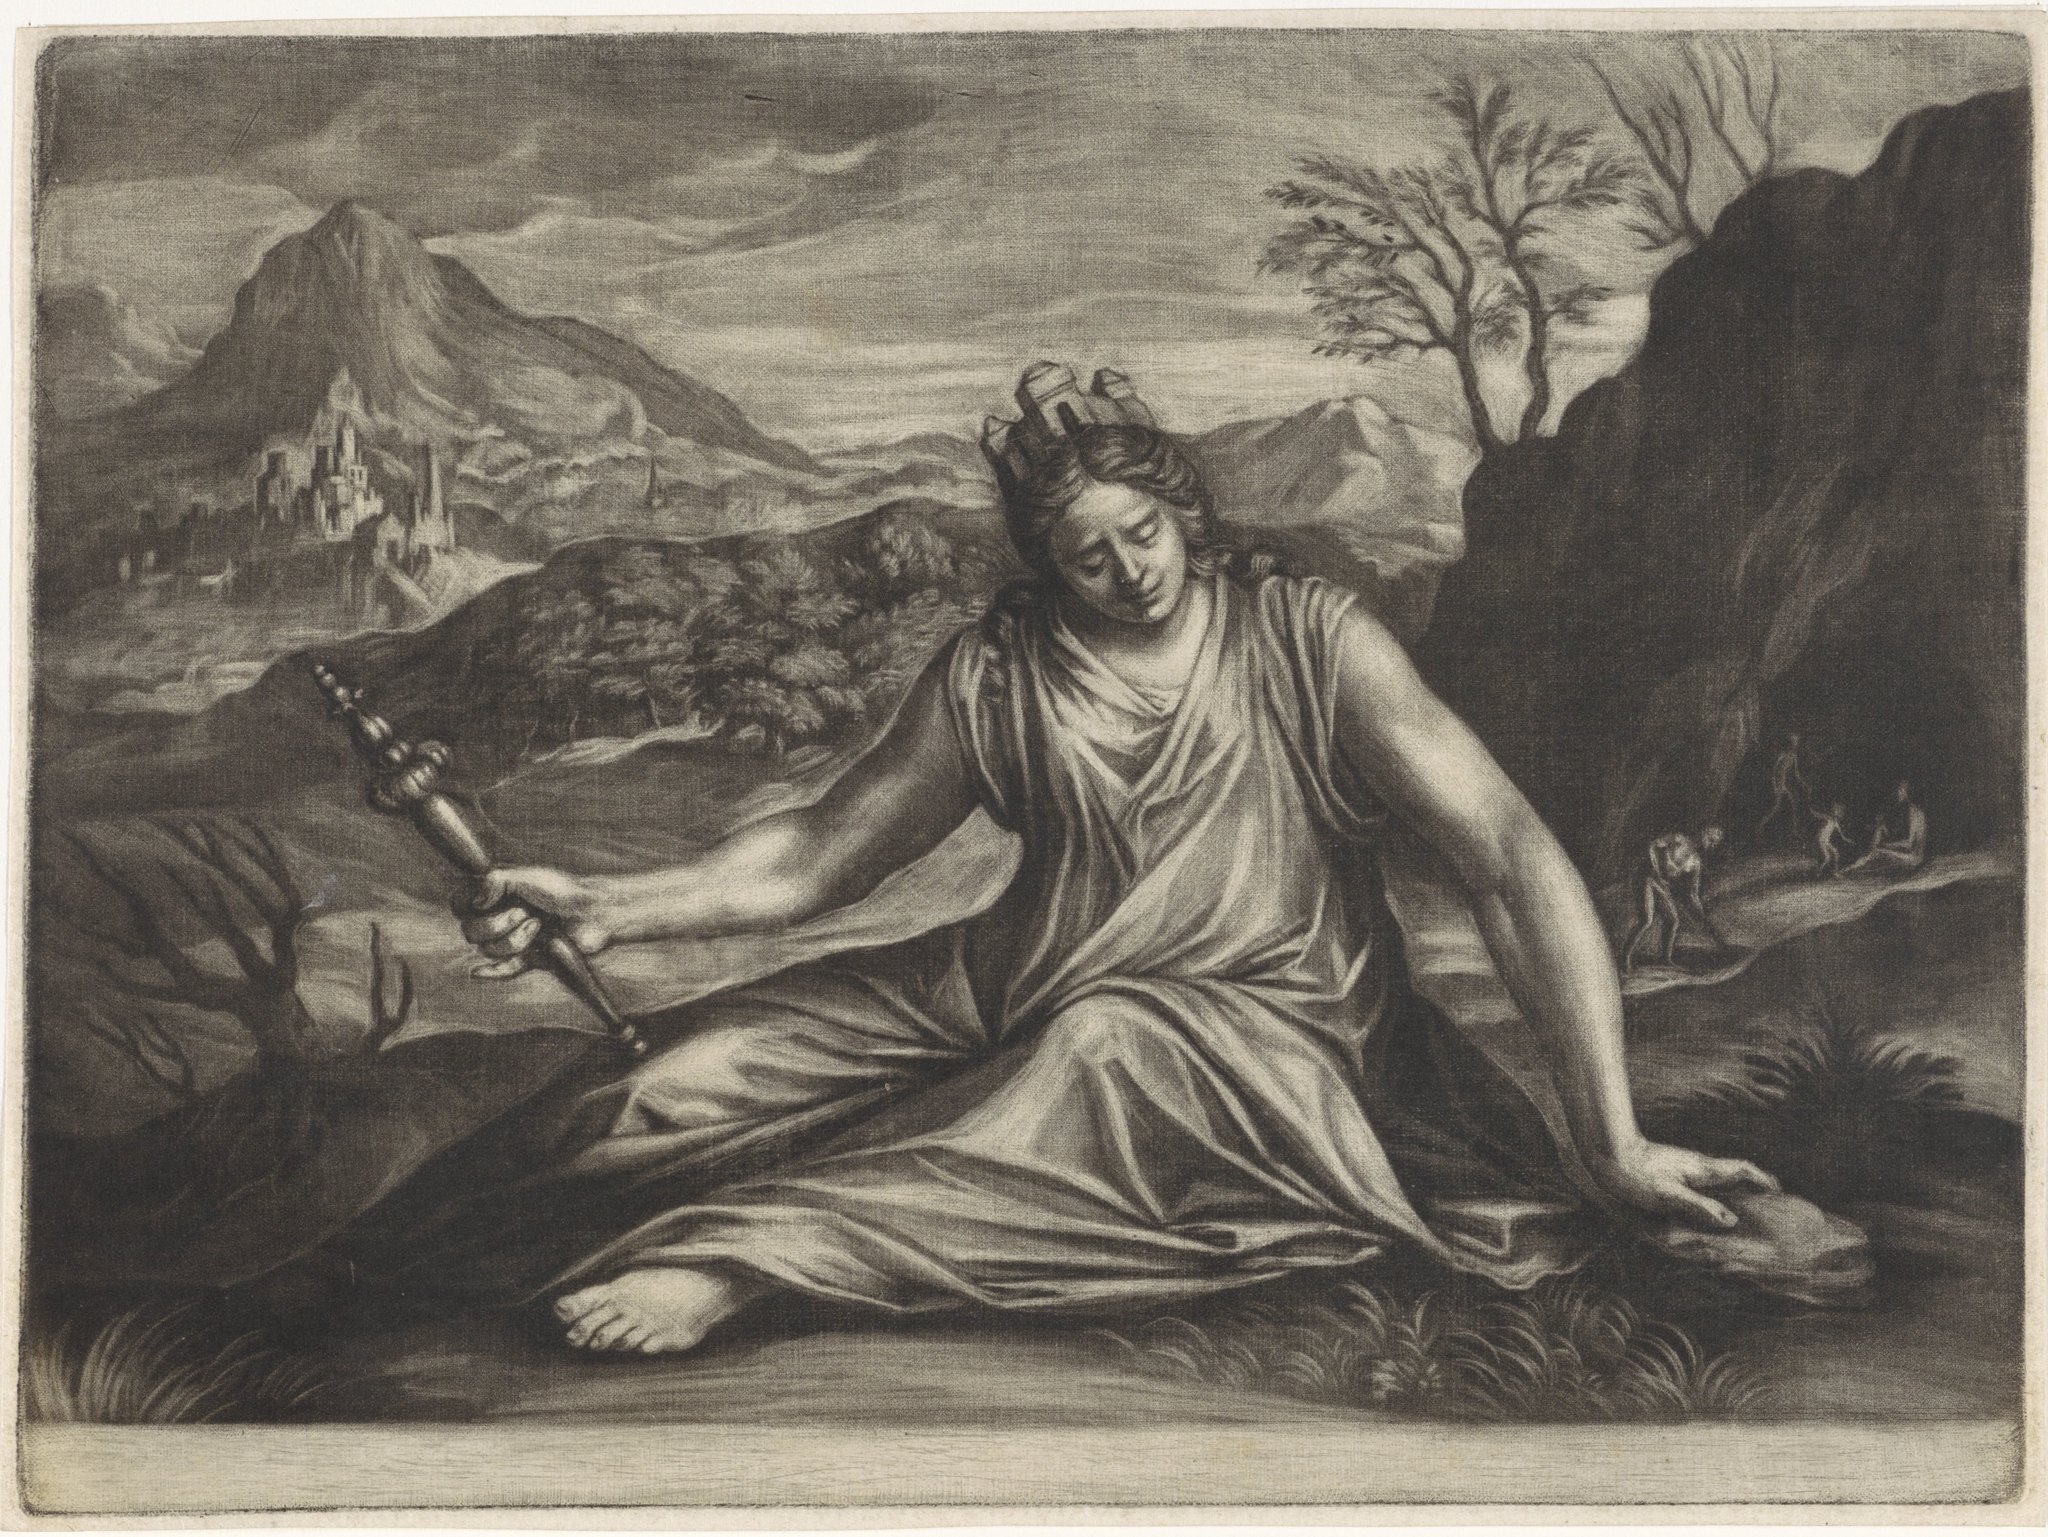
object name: print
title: Aarde gepersonifieerd door de godin Cybele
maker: Anonymous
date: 1650-1800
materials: paper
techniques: mezzotint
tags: (story of) cybele, rhea cybele, great mother of the gods (berecynt(h)ia), 'terra', 'carro della terra' (ripa)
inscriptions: collector's mark: Lugt 2228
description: Het element aarde, gepersonifieerd door de godin Cybele. Ze draagt een stedenkroon en houdt een scepter in de hand. Op de achtergrond enkele mensen bij een grot. De prent is deel van een vierdelige serie over de vier elementen.